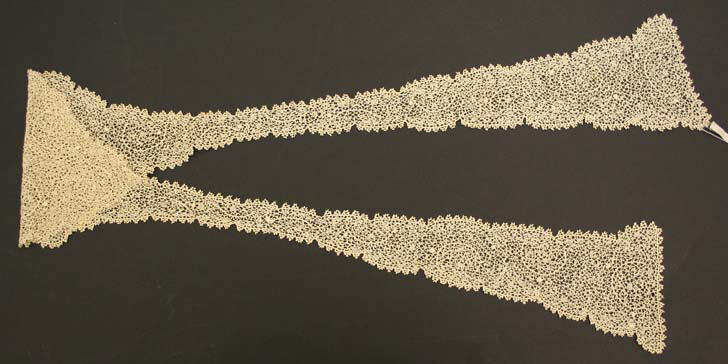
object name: cap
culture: irish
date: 1801-1900